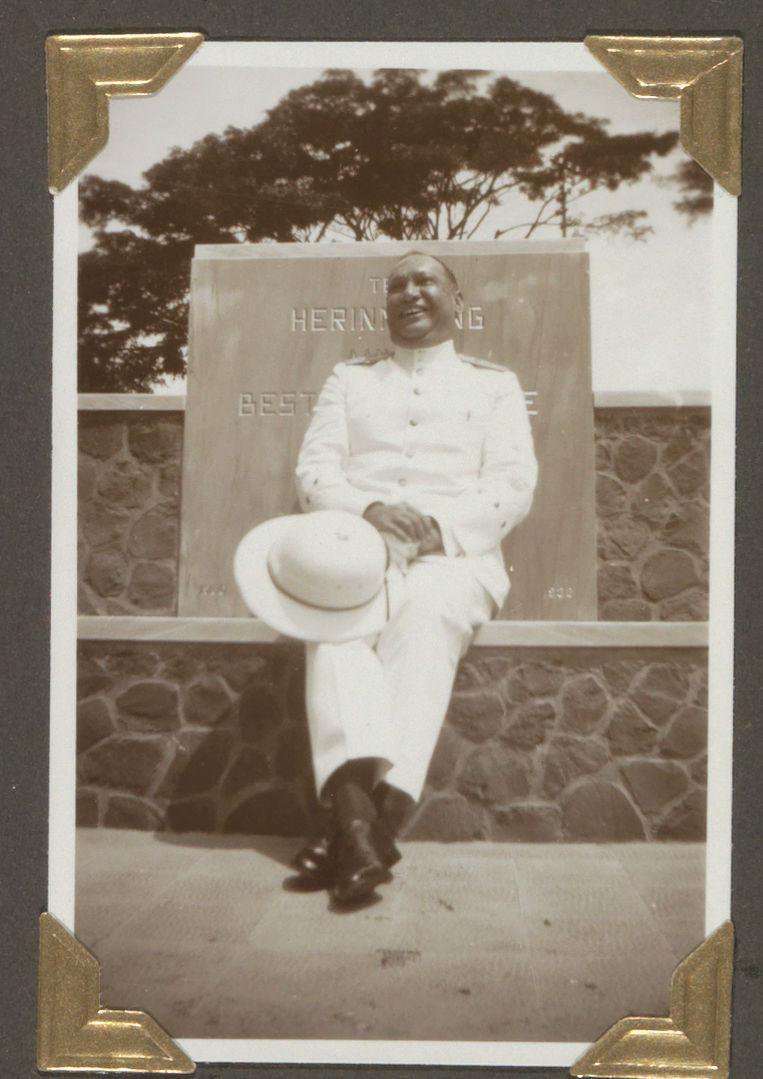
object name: photograph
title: Scheidend resident F.J. Junius zittend op de zo juist onthulde 'Junius-bank' in Tandjongkarang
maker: Anonymous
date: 1933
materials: photographic support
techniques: gelatin silver print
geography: lampung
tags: official; civil servant; functionary (in general), monument, statue, colonial government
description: De 'Junius-bank' werd in Tandjongkarang op 21 mei 1933 onthuld ter herinnering aan de bestuursperiode (1930-1933) van resident F.J. Junius.